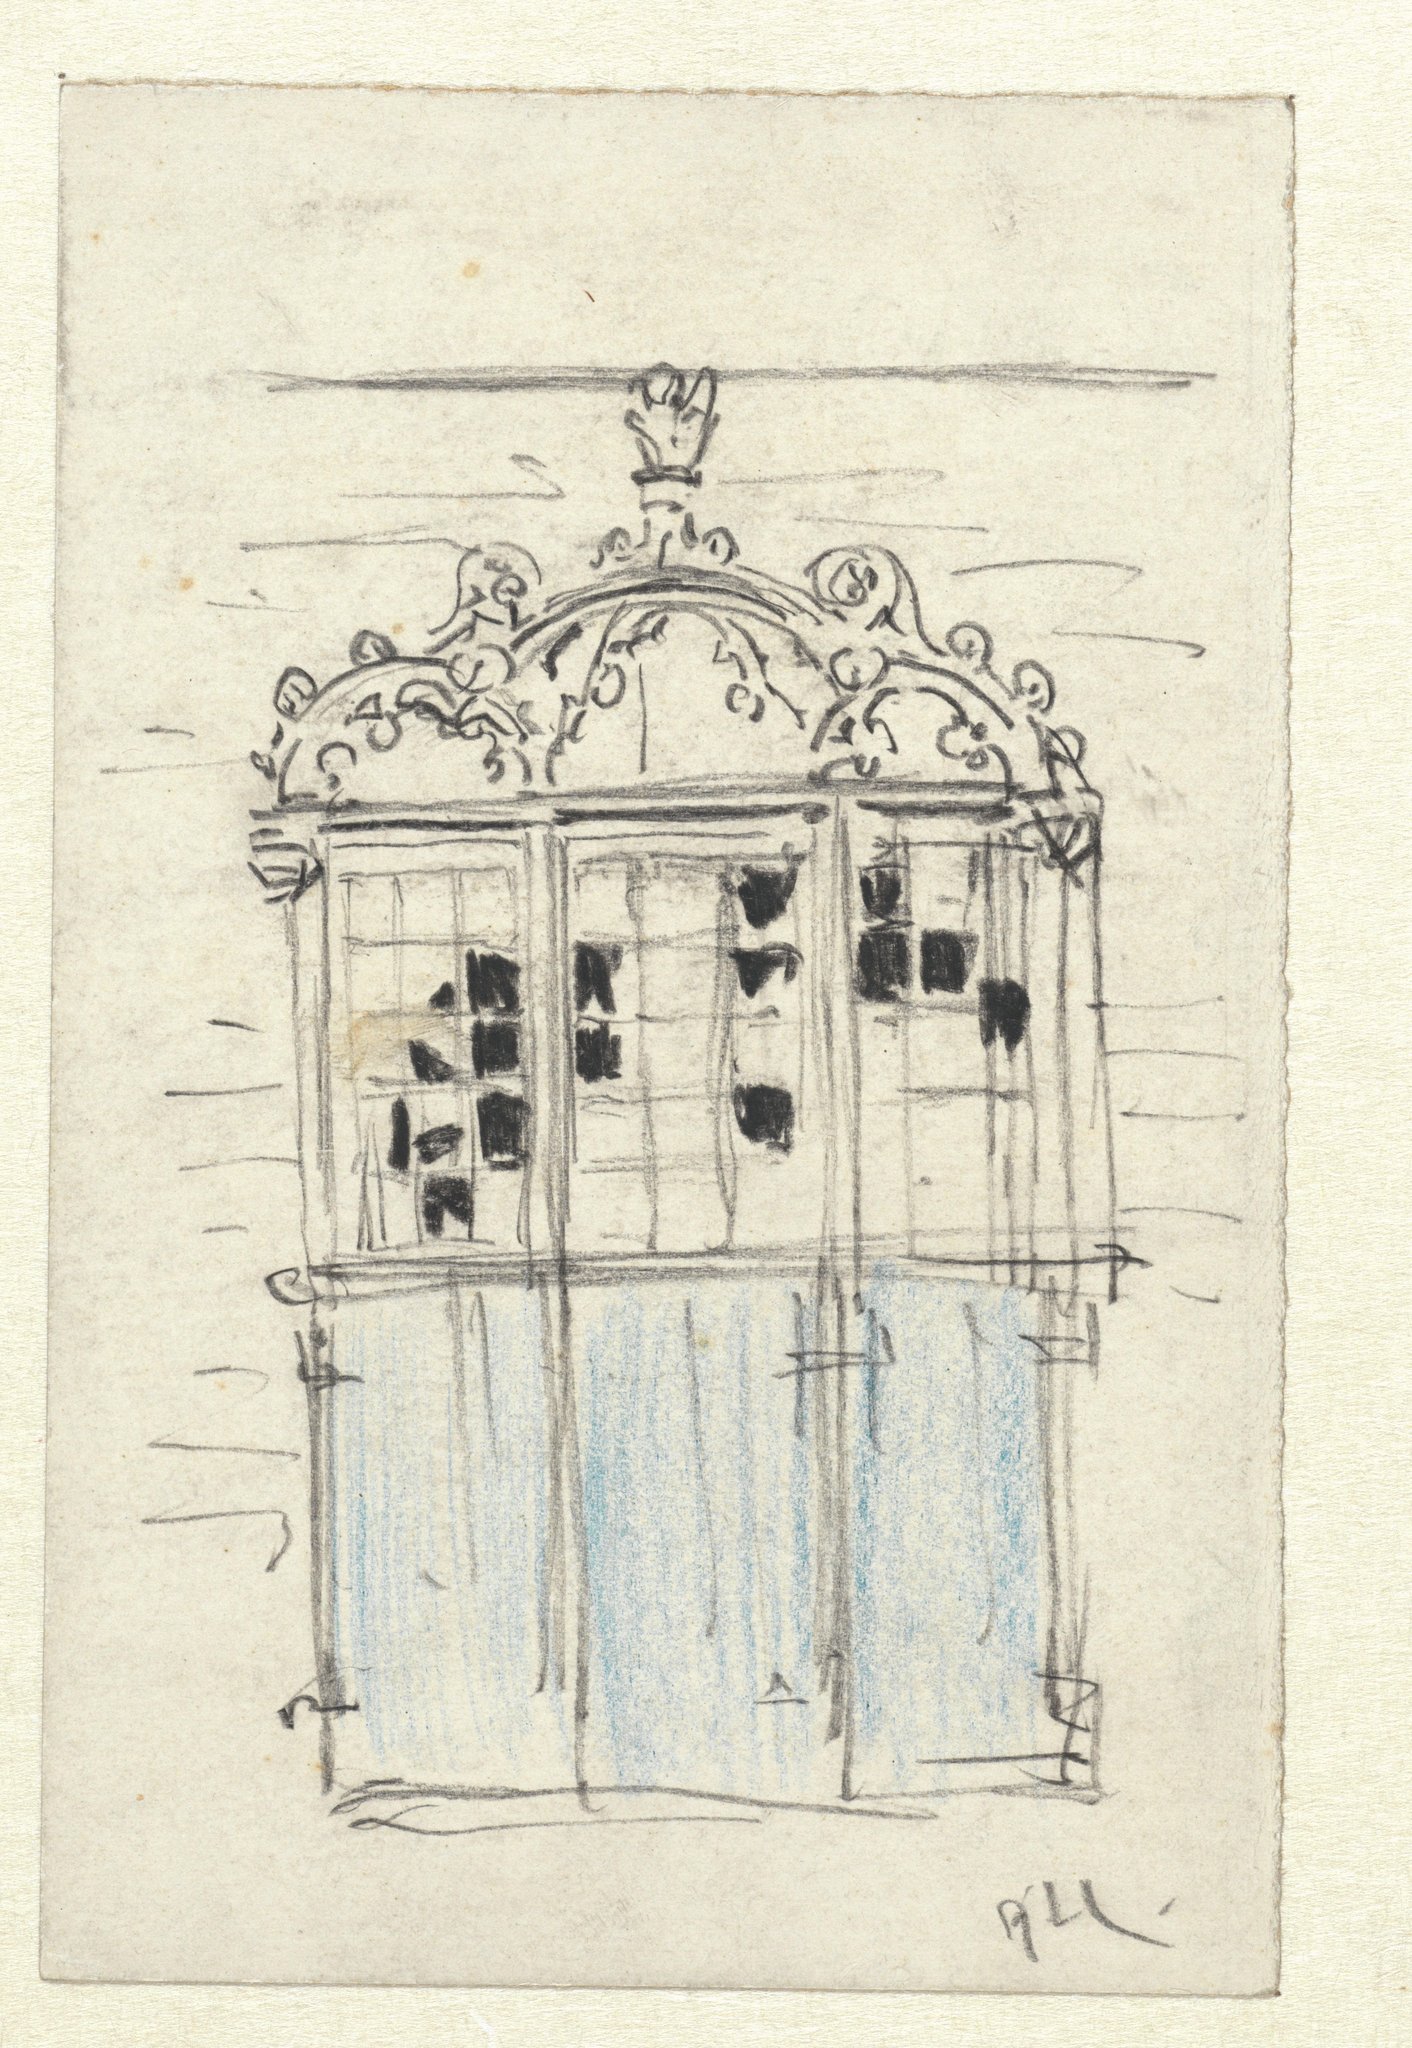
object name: drawing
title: Gotisch venster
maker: adolf le comte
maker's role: draughtsman, painter, print maker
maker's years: 1850-1921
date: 1860-1921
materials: chalk, paper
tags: window